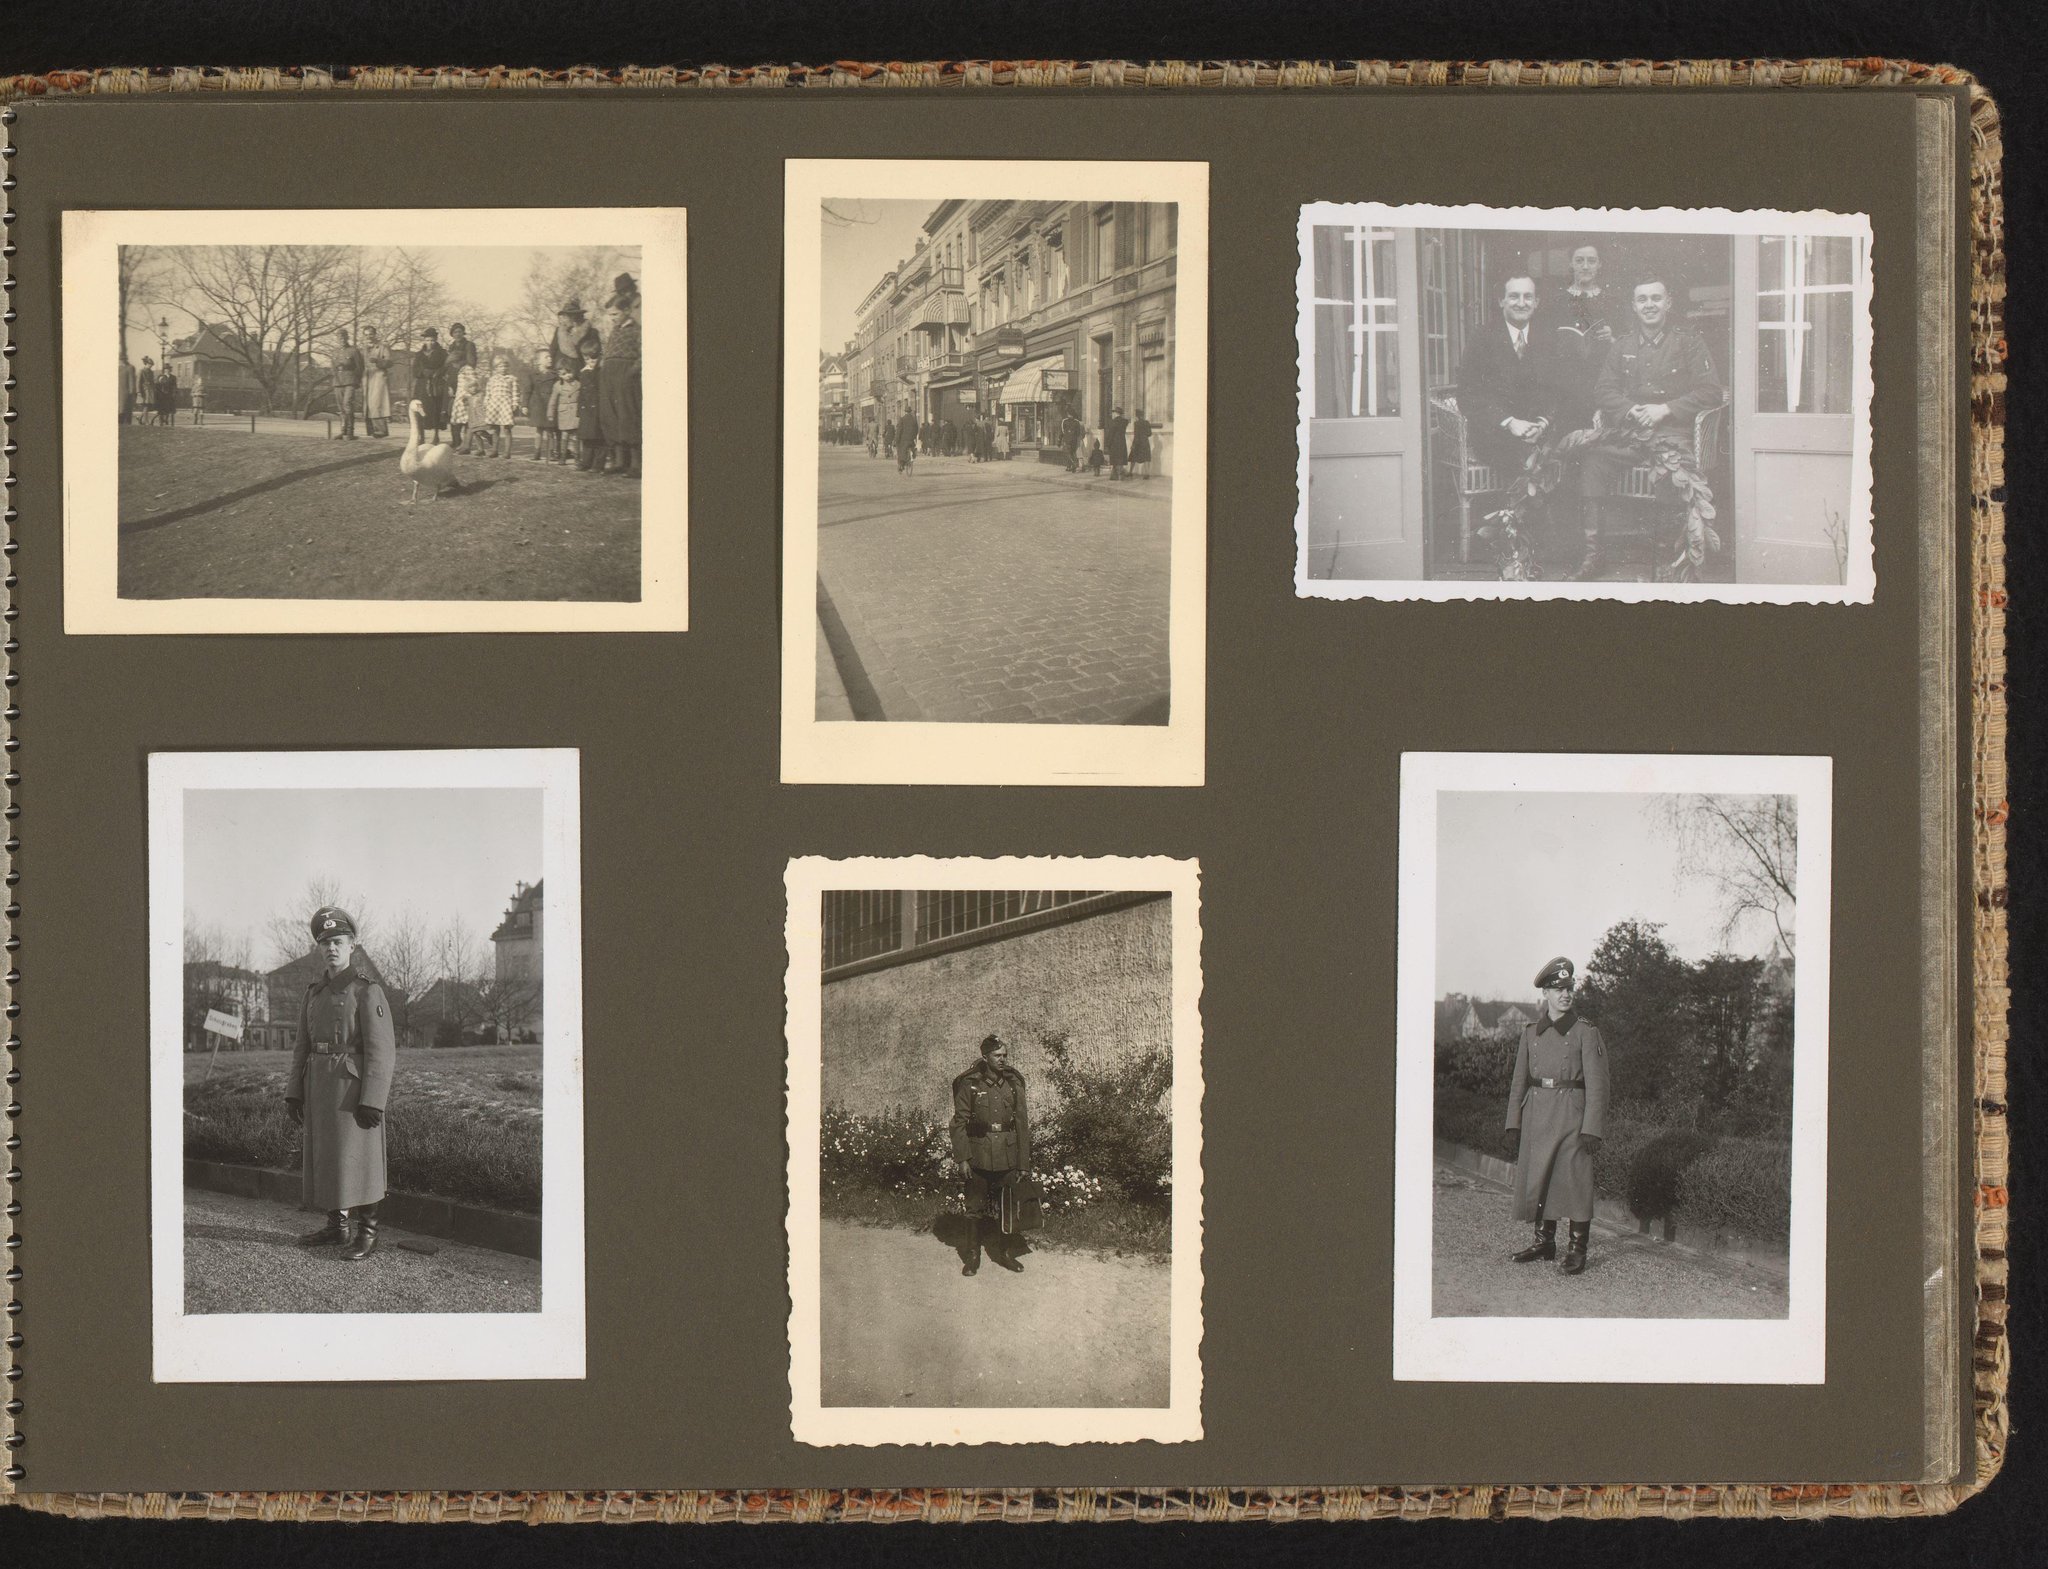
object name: photograph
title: Breda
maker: Anonymous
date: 1940-1943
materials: cardboard, photographic support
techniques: gelatin silver print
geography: breda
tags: the soldier; the soldier's life, public road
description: Albumblad met zes foto's van de samensteller van het album, met vader en moeder en poserend op straat, sommige foto's in Breda. Onderdeel van het fotoalbum Duitse bezetting van Nederland.